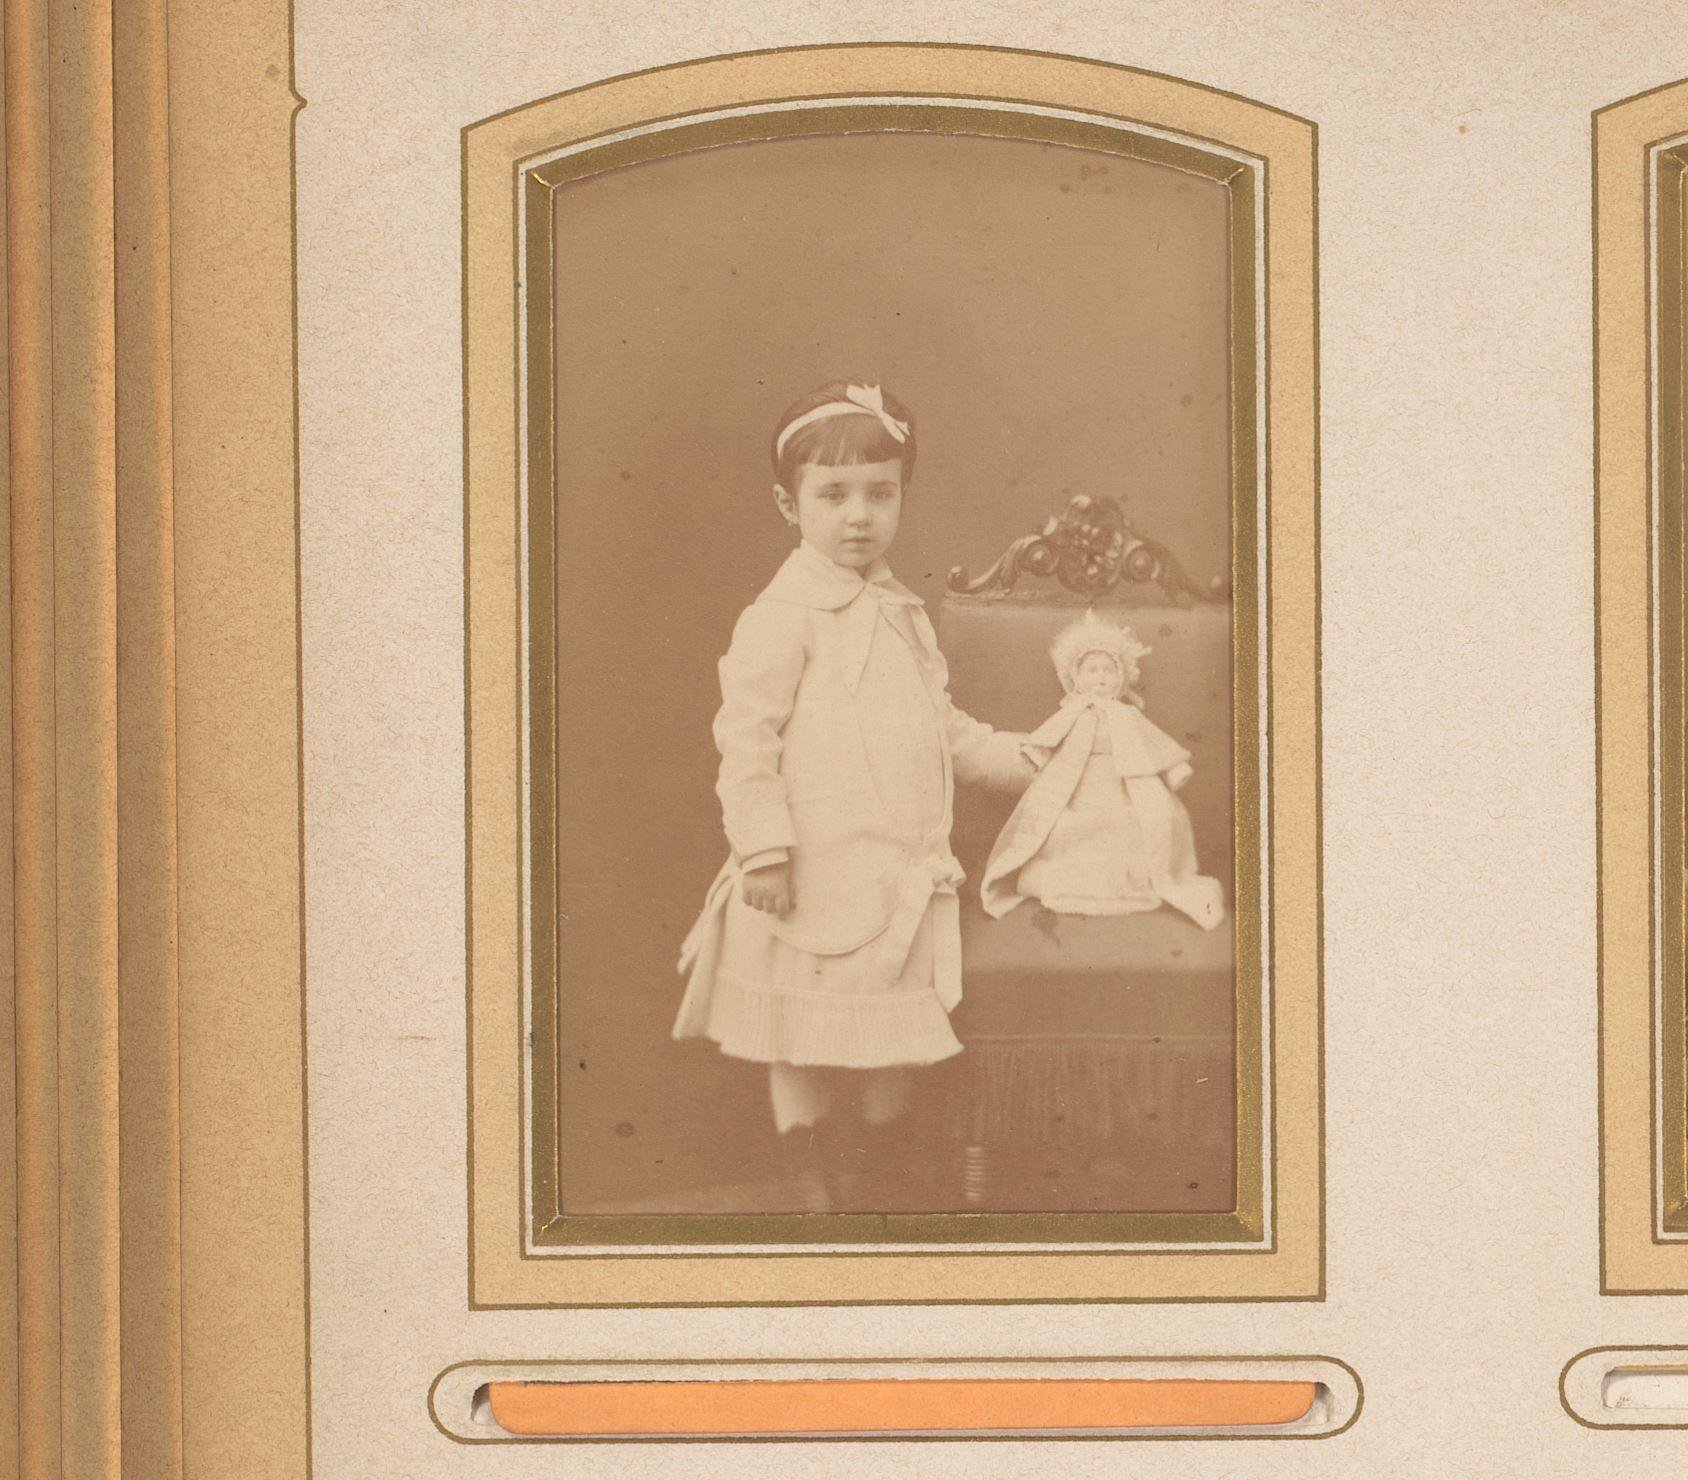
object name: photograph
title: Portret van een meisje met een pop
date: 1870-1900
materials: cardboard, photographic support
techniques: albumen print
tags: historical persons, girl (child between toddler and youth), (playing with) dolls